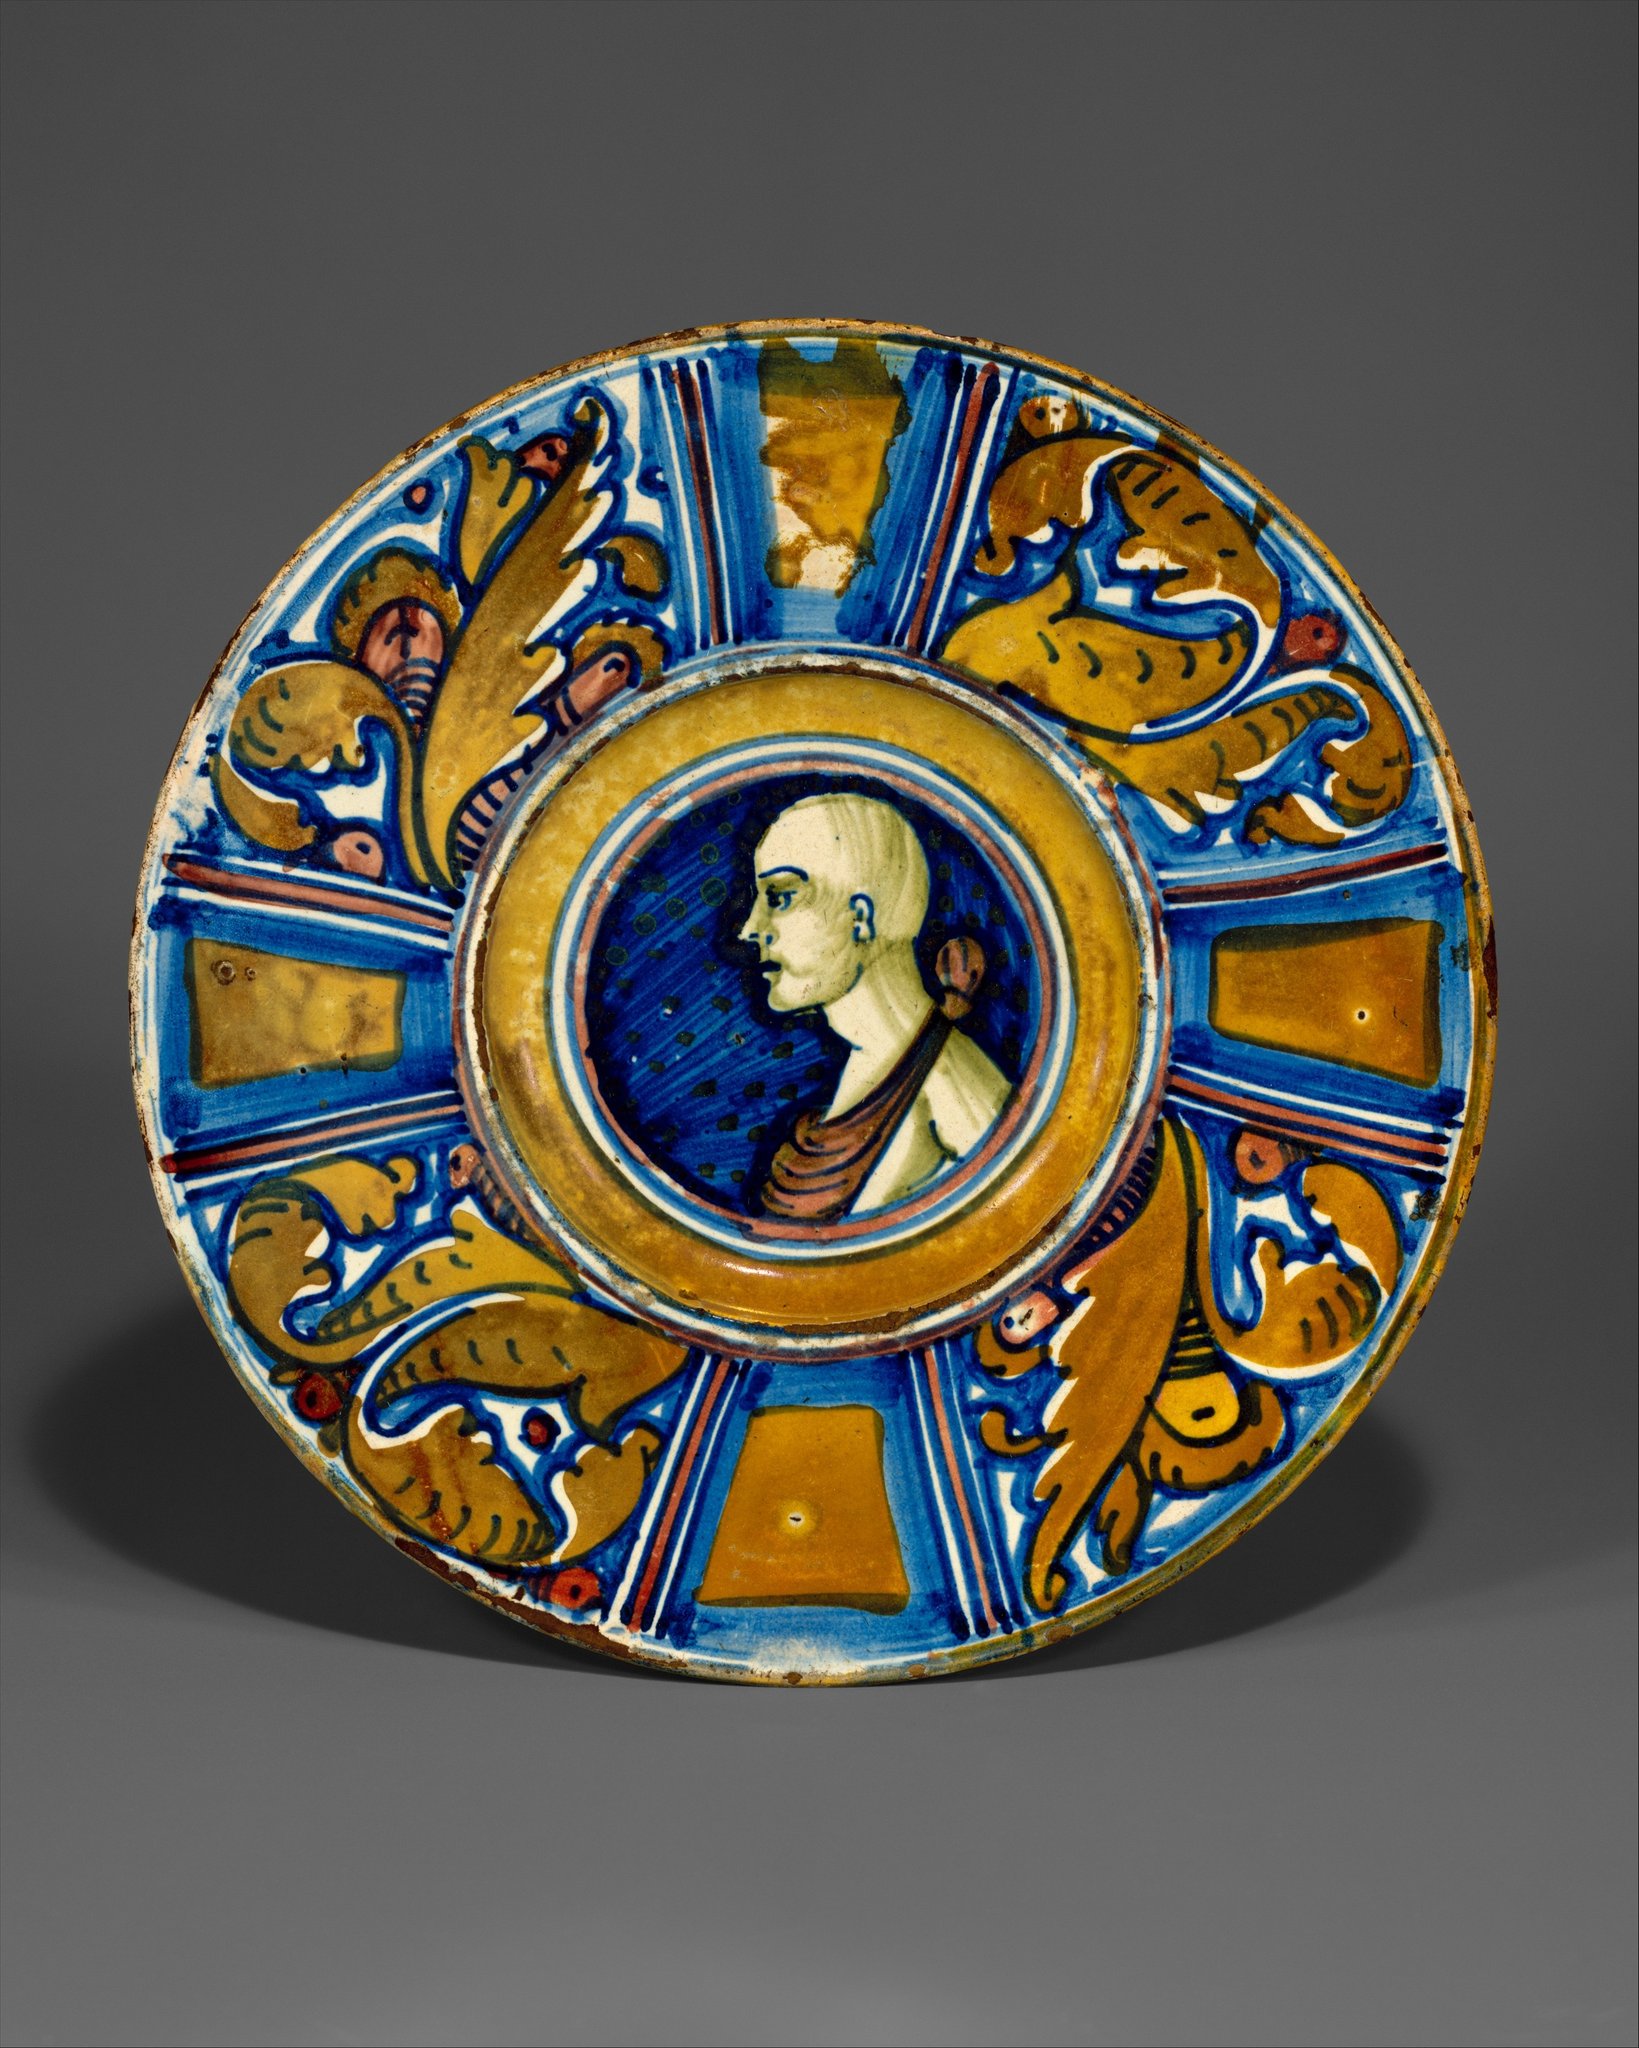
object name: plate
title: Plate (tagliere)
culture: italian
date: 1530-1535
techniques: maiolica, glazing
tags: men,profiles